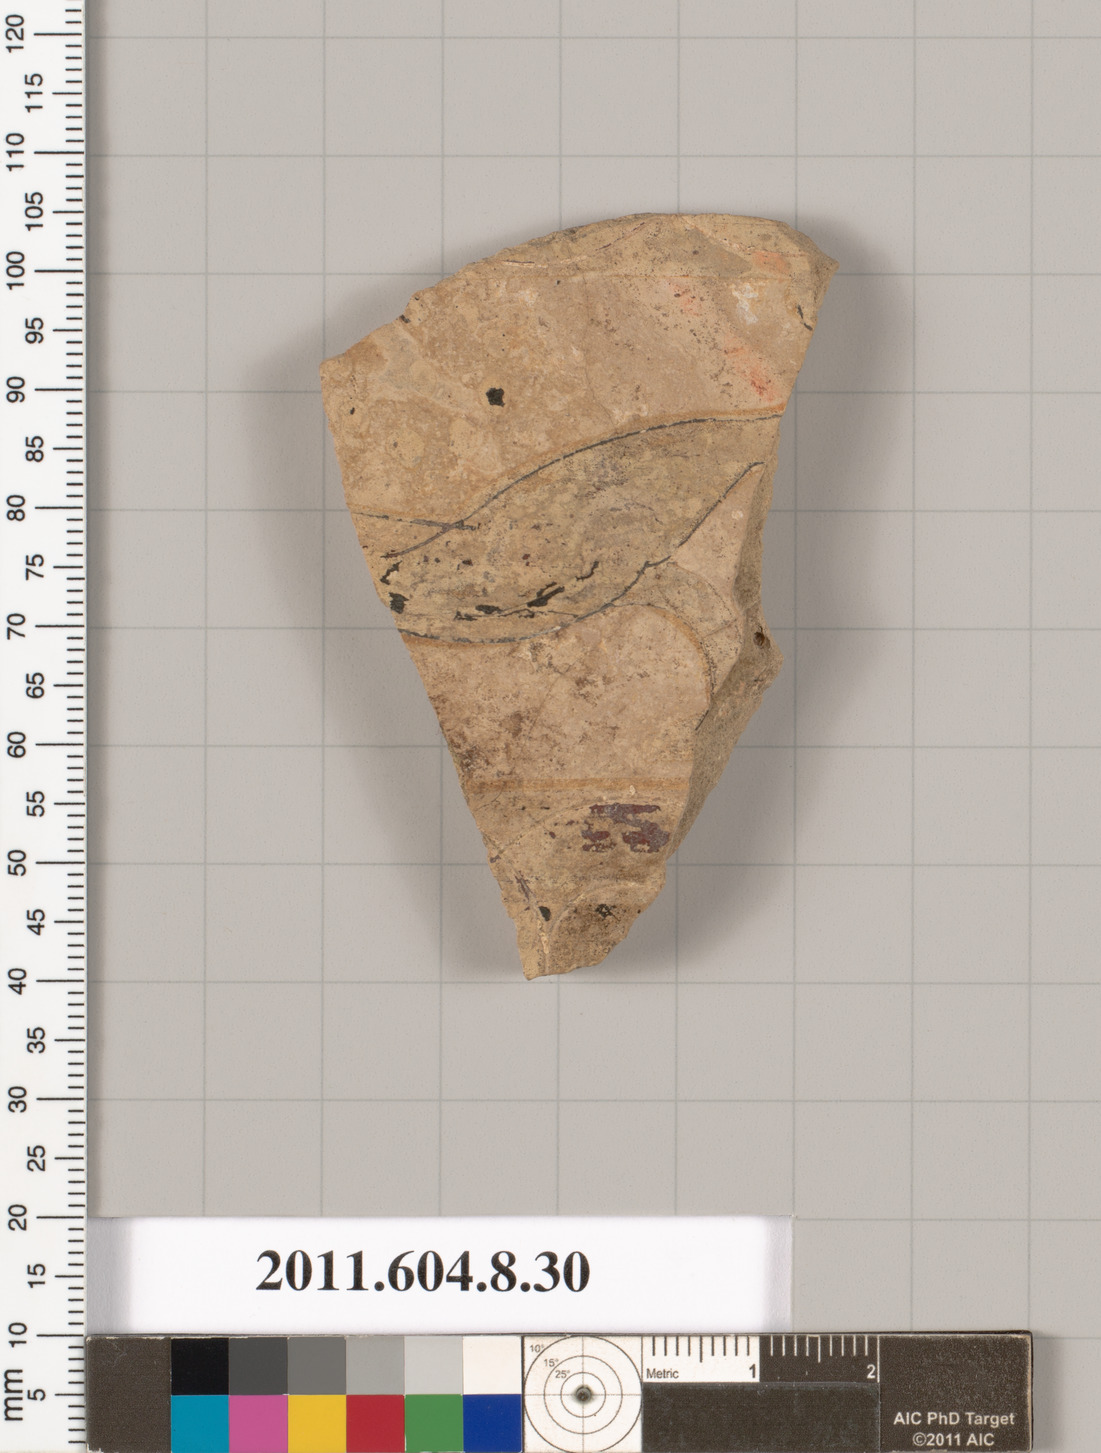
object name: amphora fragment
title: Terracotta fragment of an amphora (jar)?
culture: etruscan, etrusco-corinthian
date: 625-601 BCE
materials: terracotta